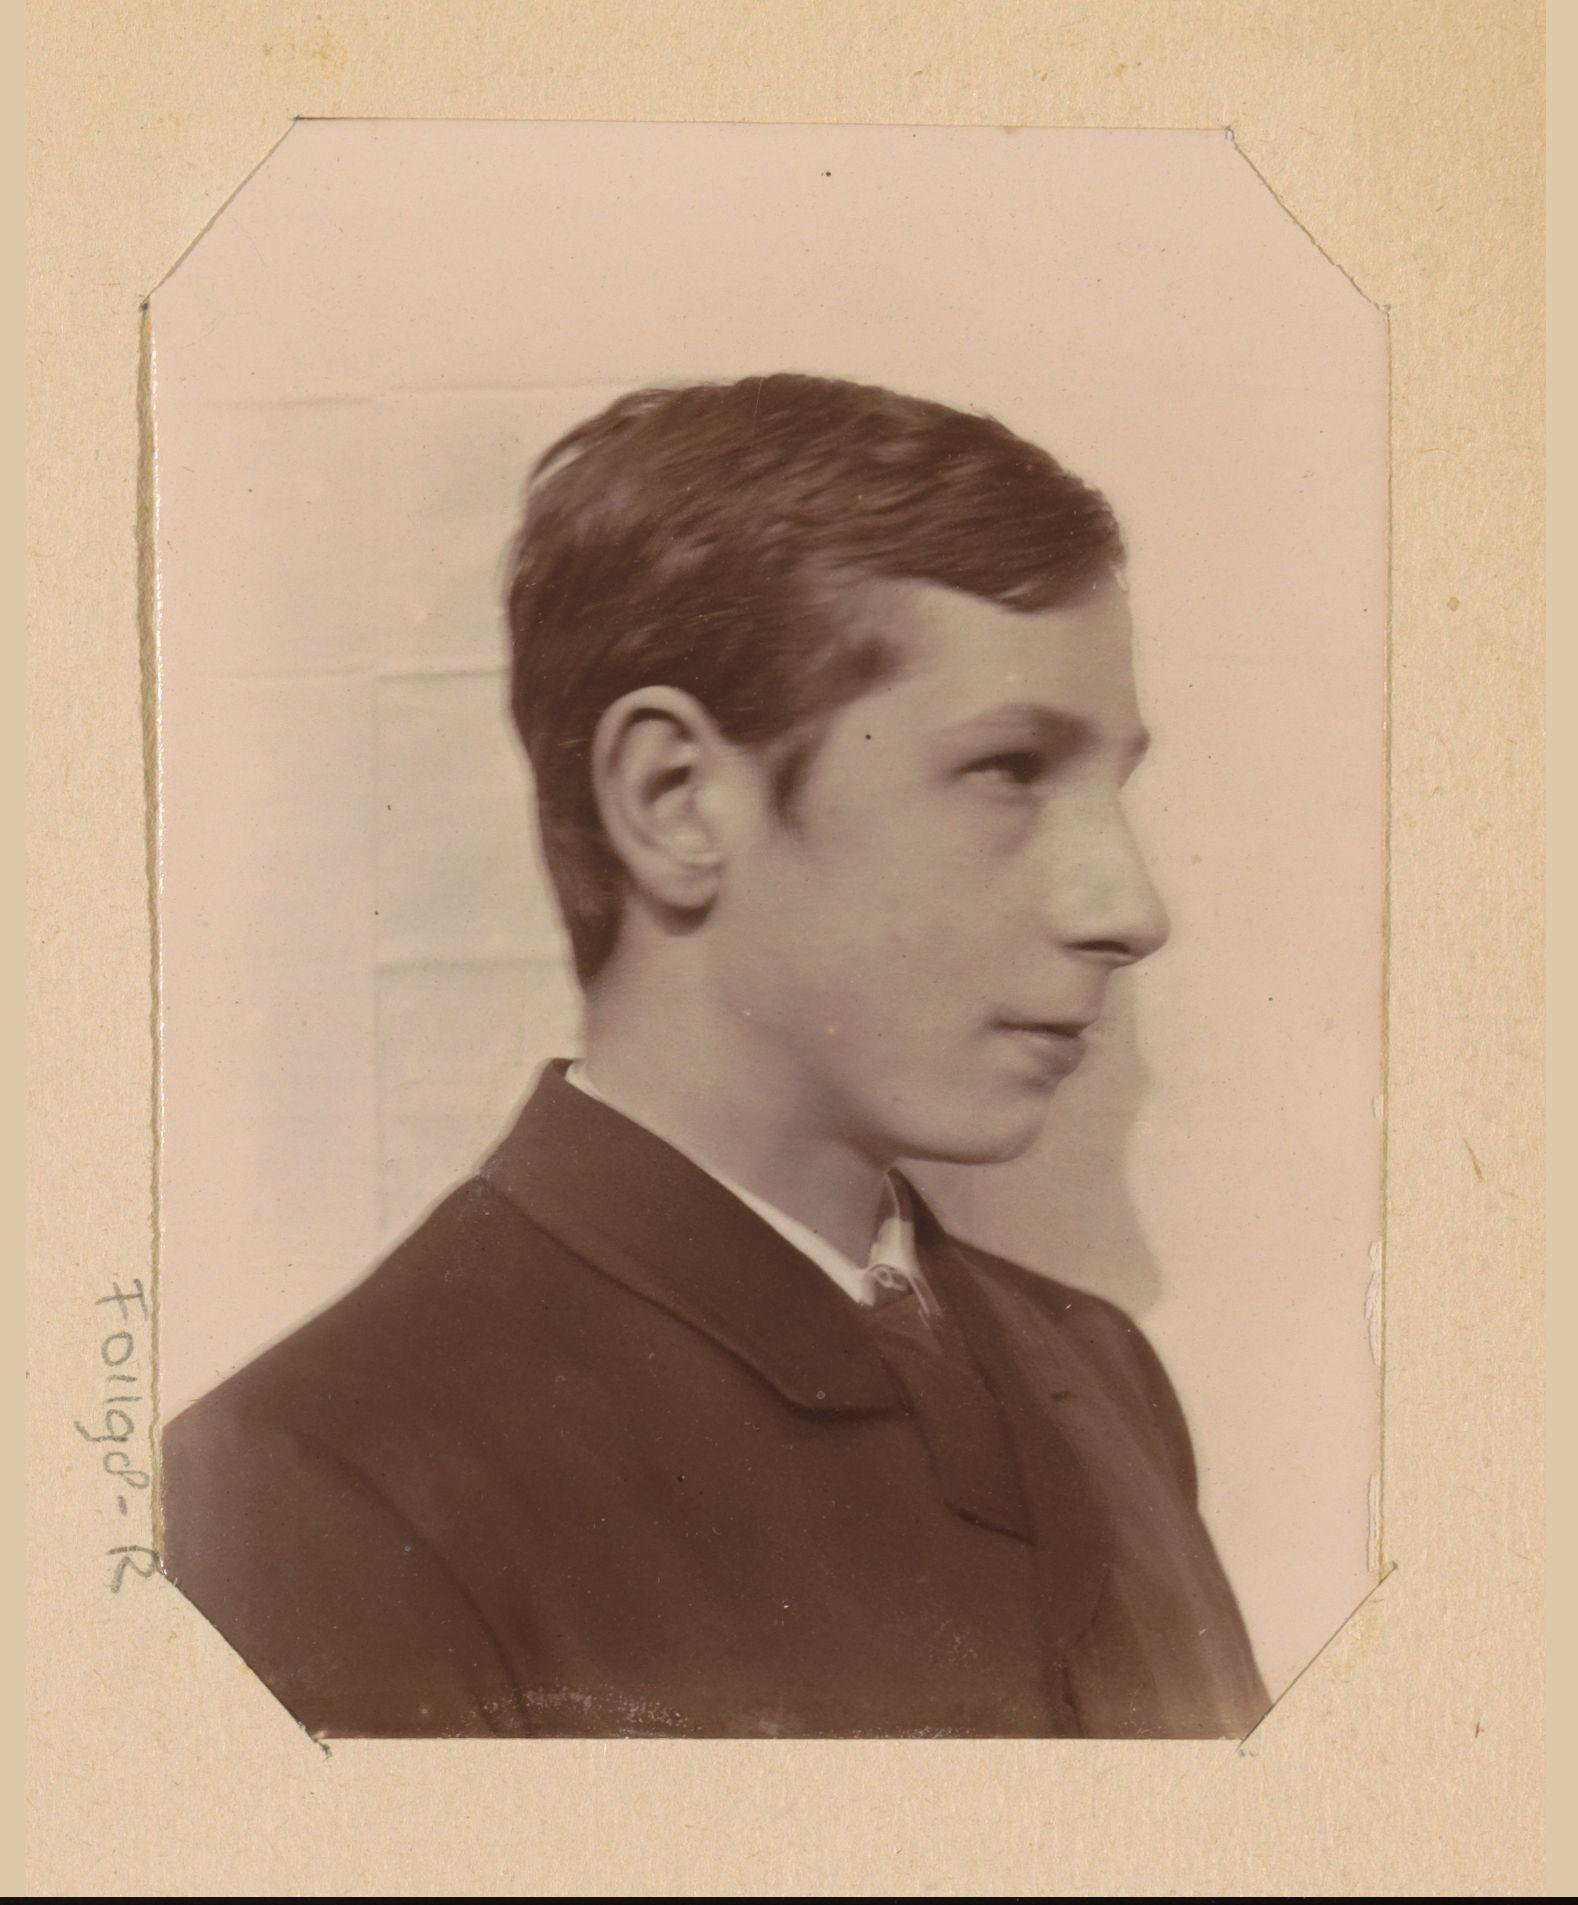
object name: photograph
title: Portret van een onbekende jonge man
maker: johanna margaretha piek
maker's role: fotograaf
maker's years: 1870-1947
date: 1889-1893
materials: paper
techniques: gelatin silver print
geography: netherlands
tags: youth, adolescent, anonymous historical person portrayed, netherlands